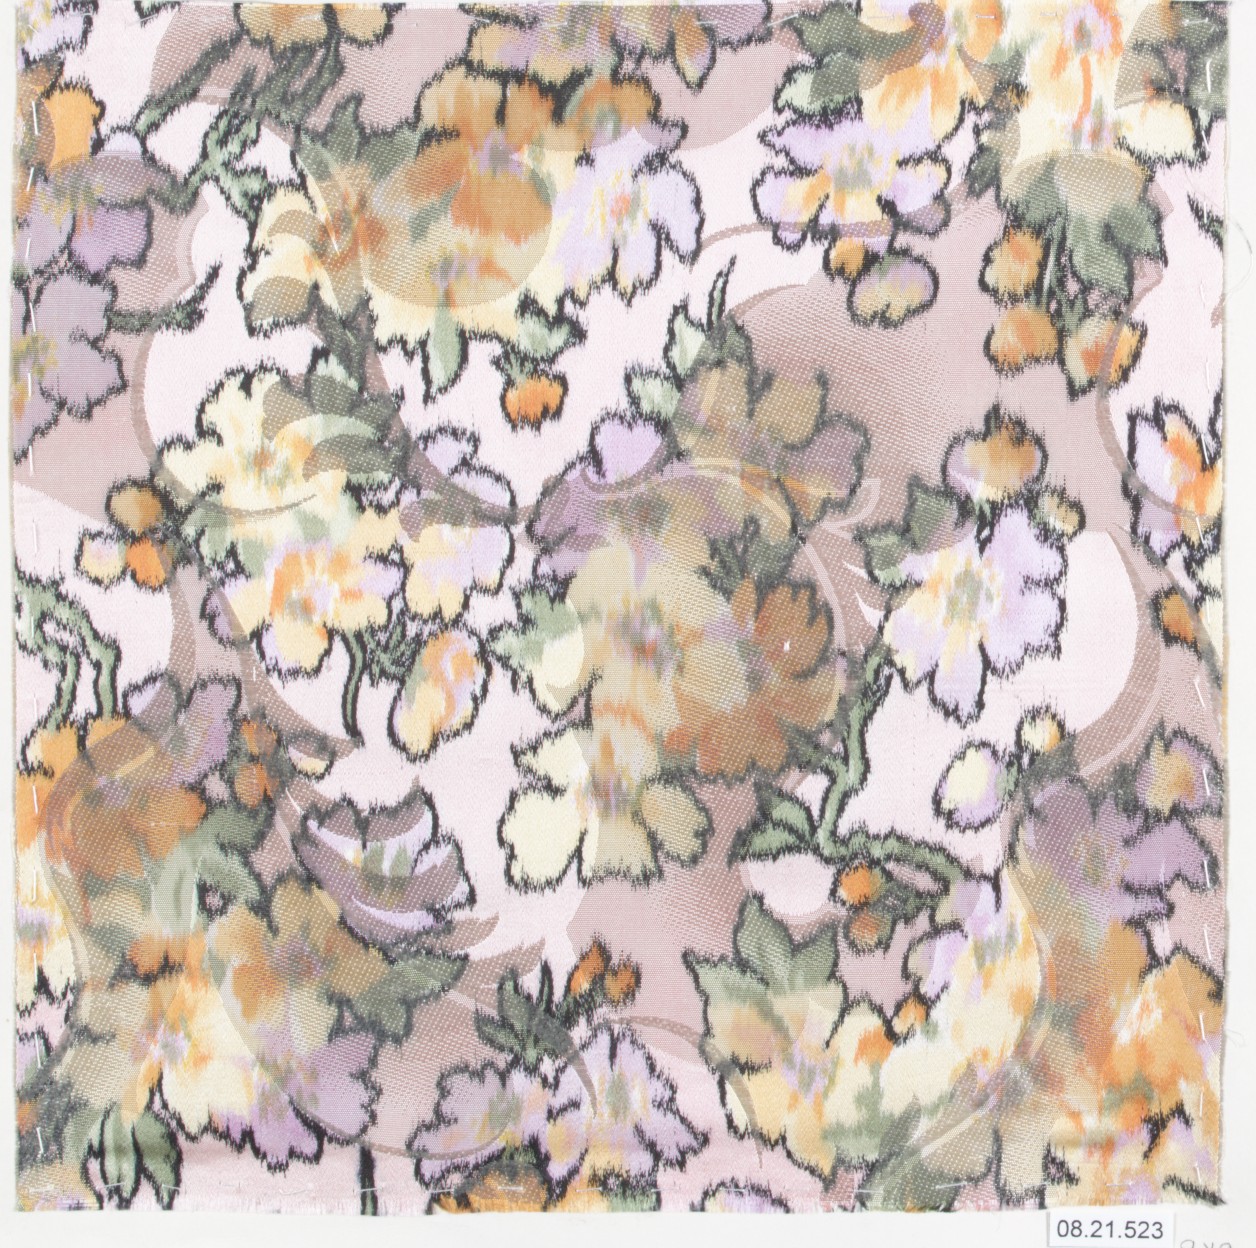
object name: textile sample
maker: Anonymous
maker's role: designer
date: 1900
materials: silk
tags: flowers